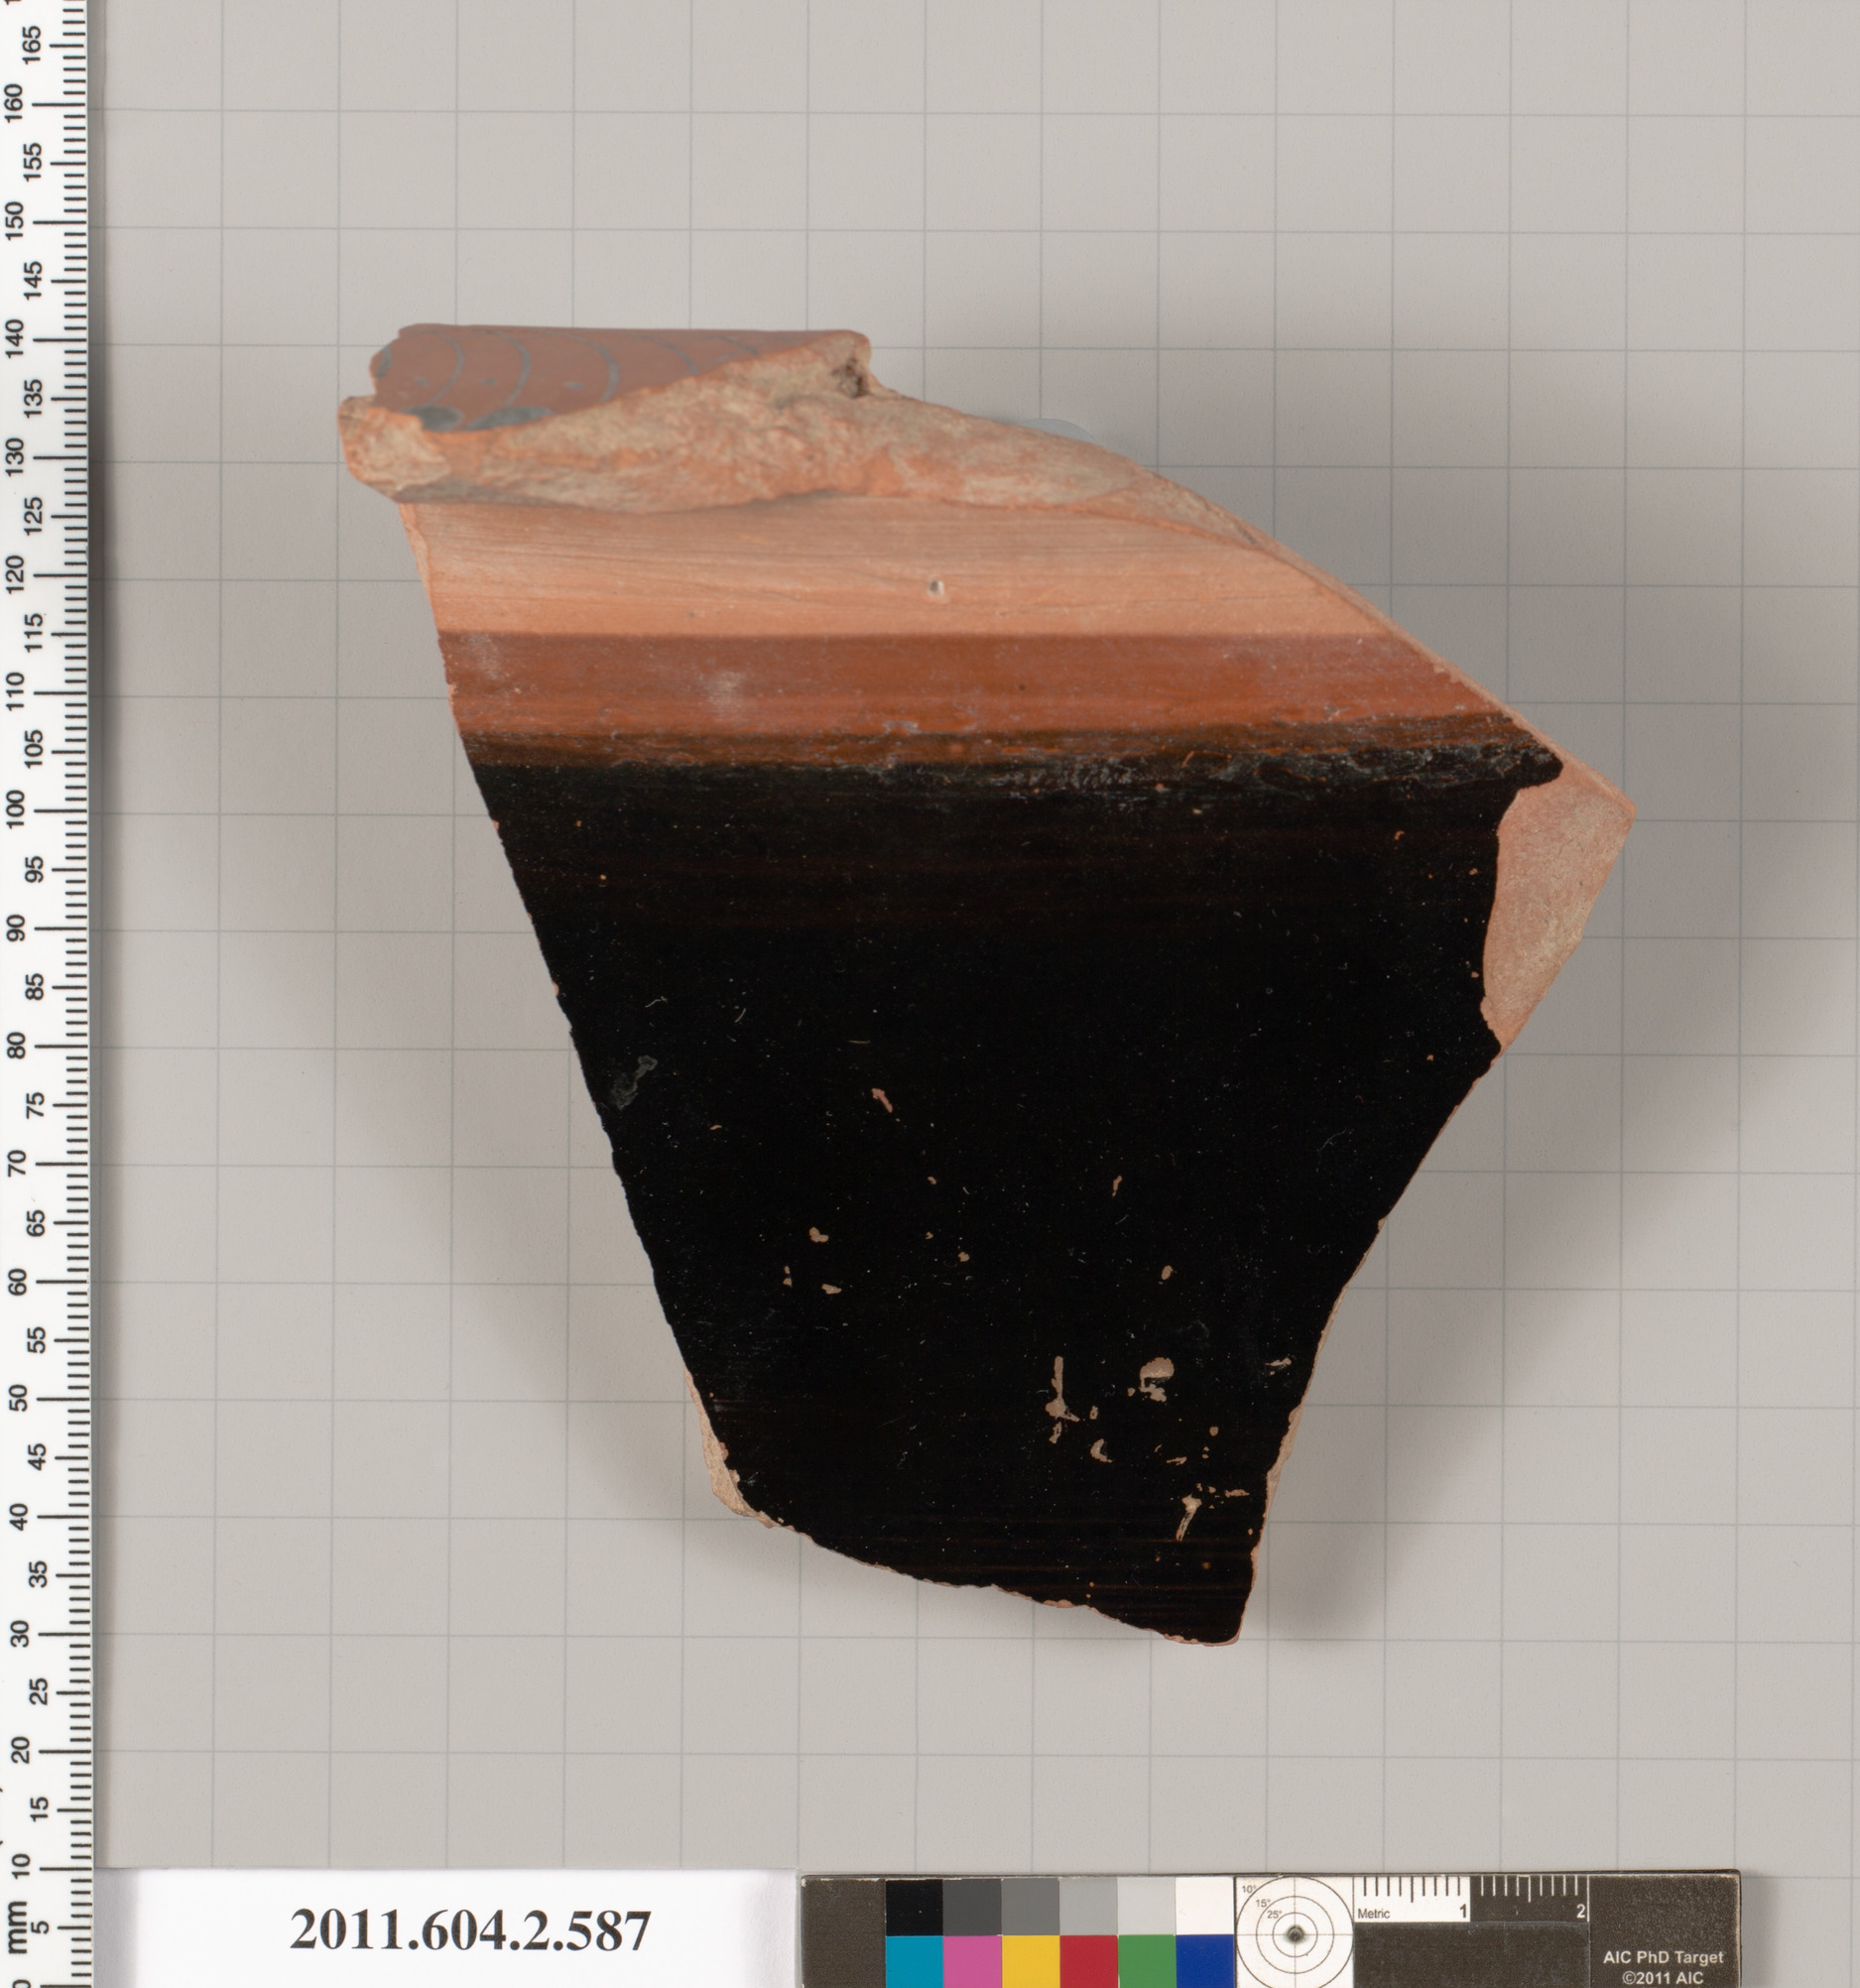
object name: column krater fragment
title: Terracotta fragment of a column-krater (bowl for mixing wine and water)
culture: greek, attic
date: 475-451 BCE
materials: terracotta